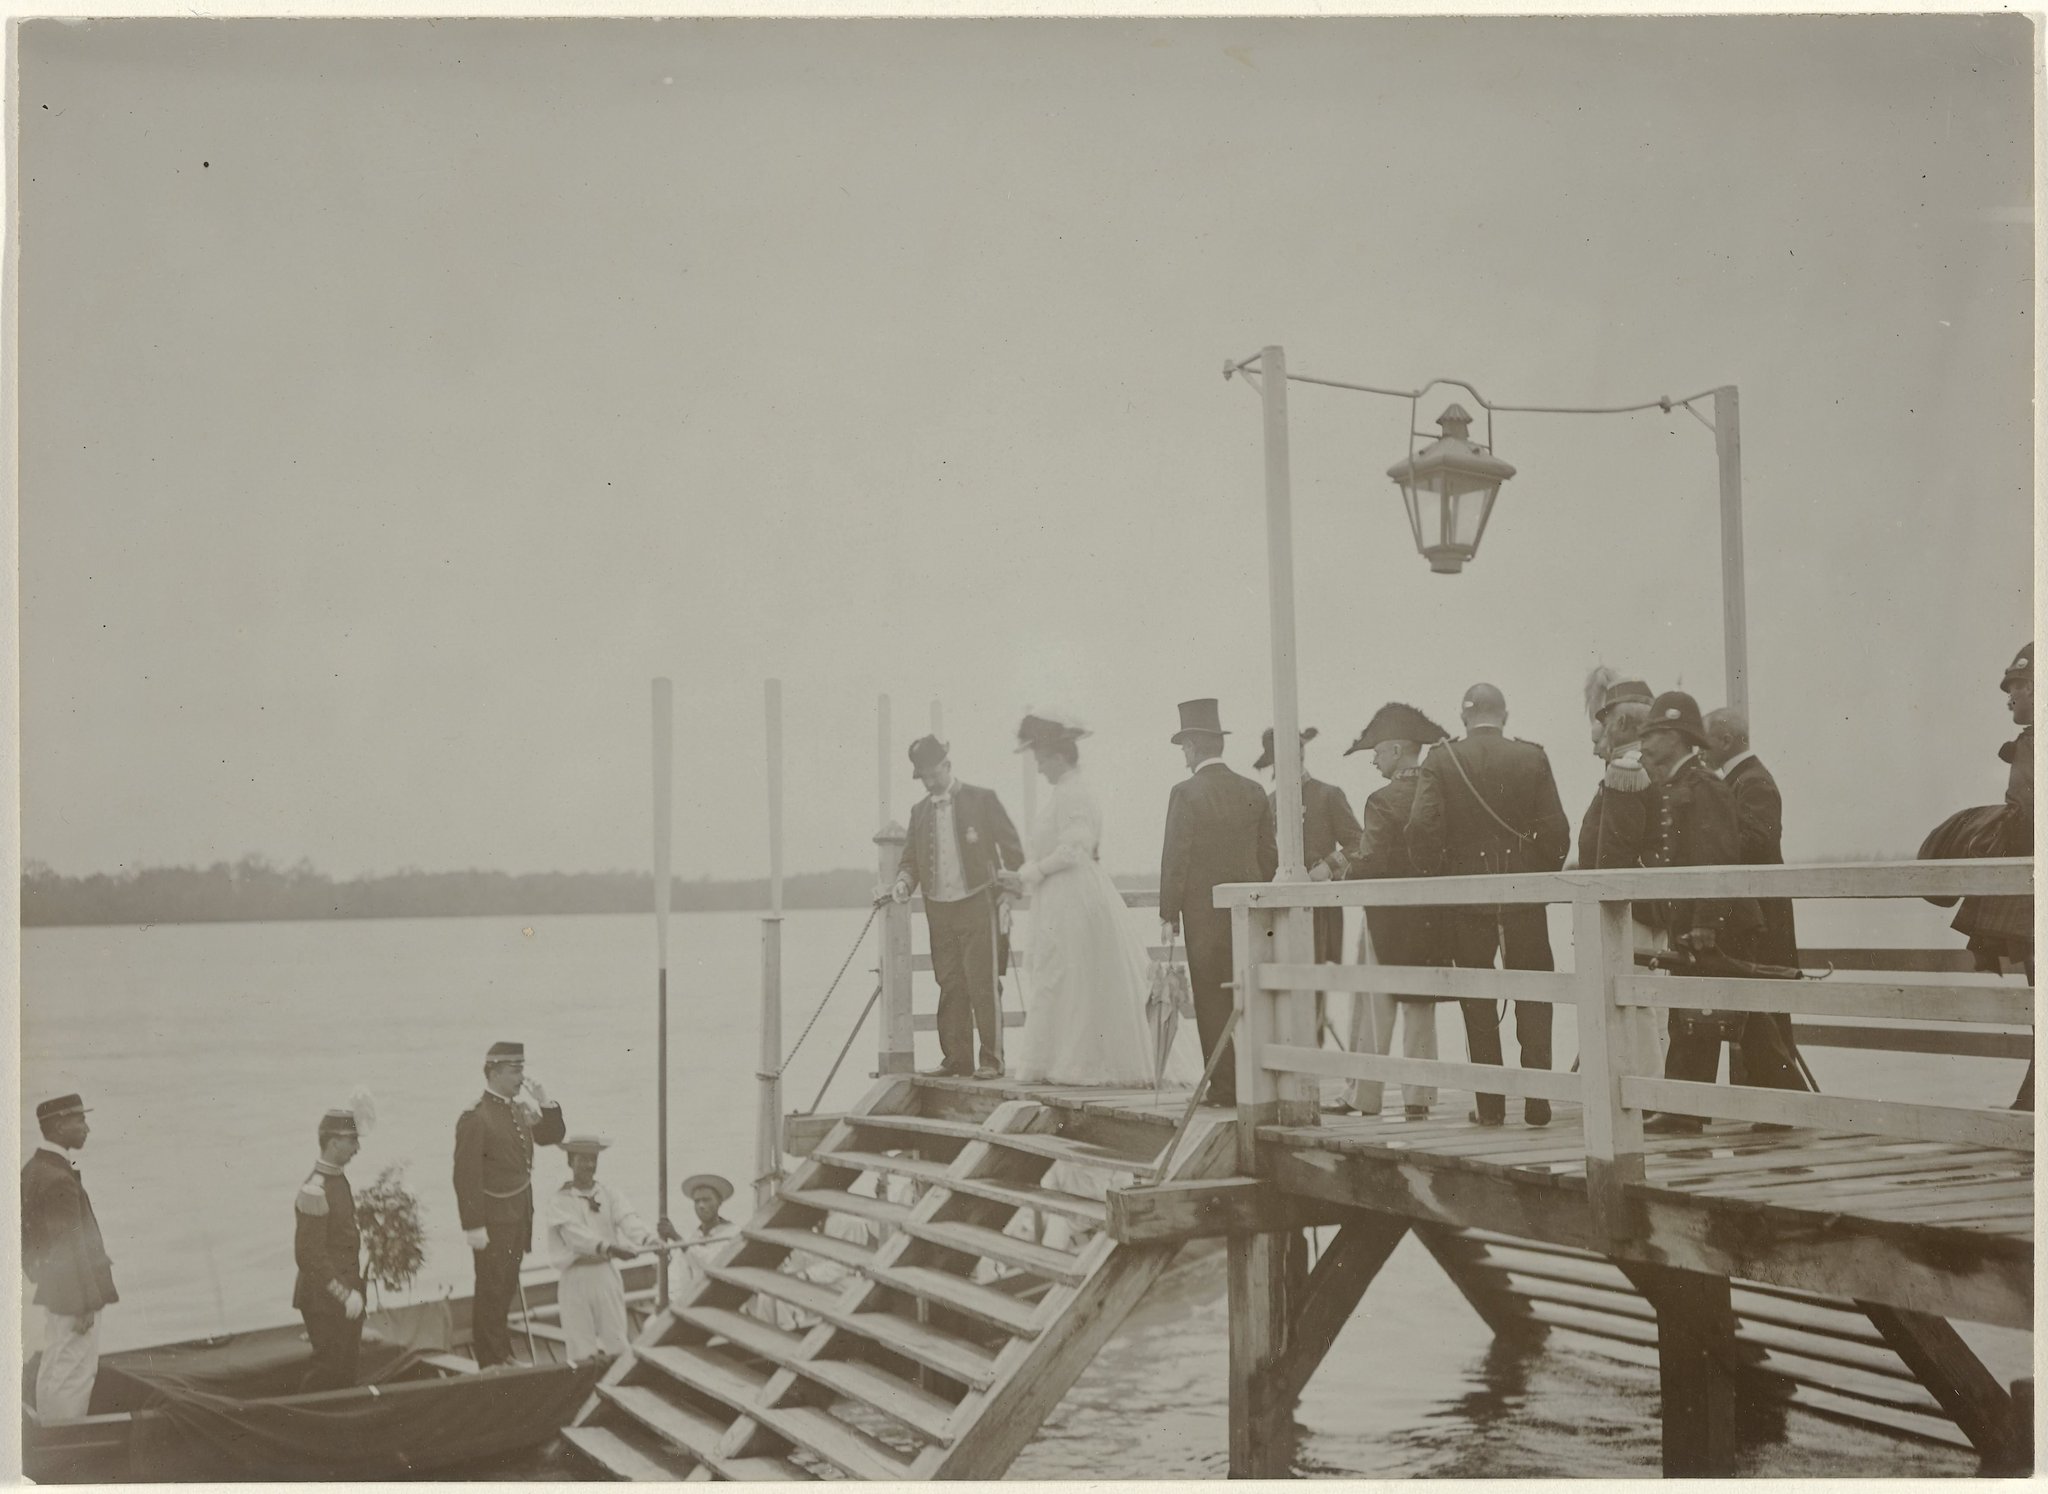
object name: photograph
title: Koninginnedag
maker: Anonymous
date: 1903-1908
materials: photographic support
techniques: photography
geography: paramaribo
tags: meppel, rechter, jurist, gouverneur, procureur-generaal, petrus hofstede crull, paramaribo (stad), koninginnedag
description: P. Hofstede Crull en zijn vrouw zijn samen met andere heren, aangekomen bij een houten pier waar een boot ligt afgemeerd. Hofstede Crull was op dat moment waarnemend Gouverneur van Suriname. Koninginnedag te Paramaribo.